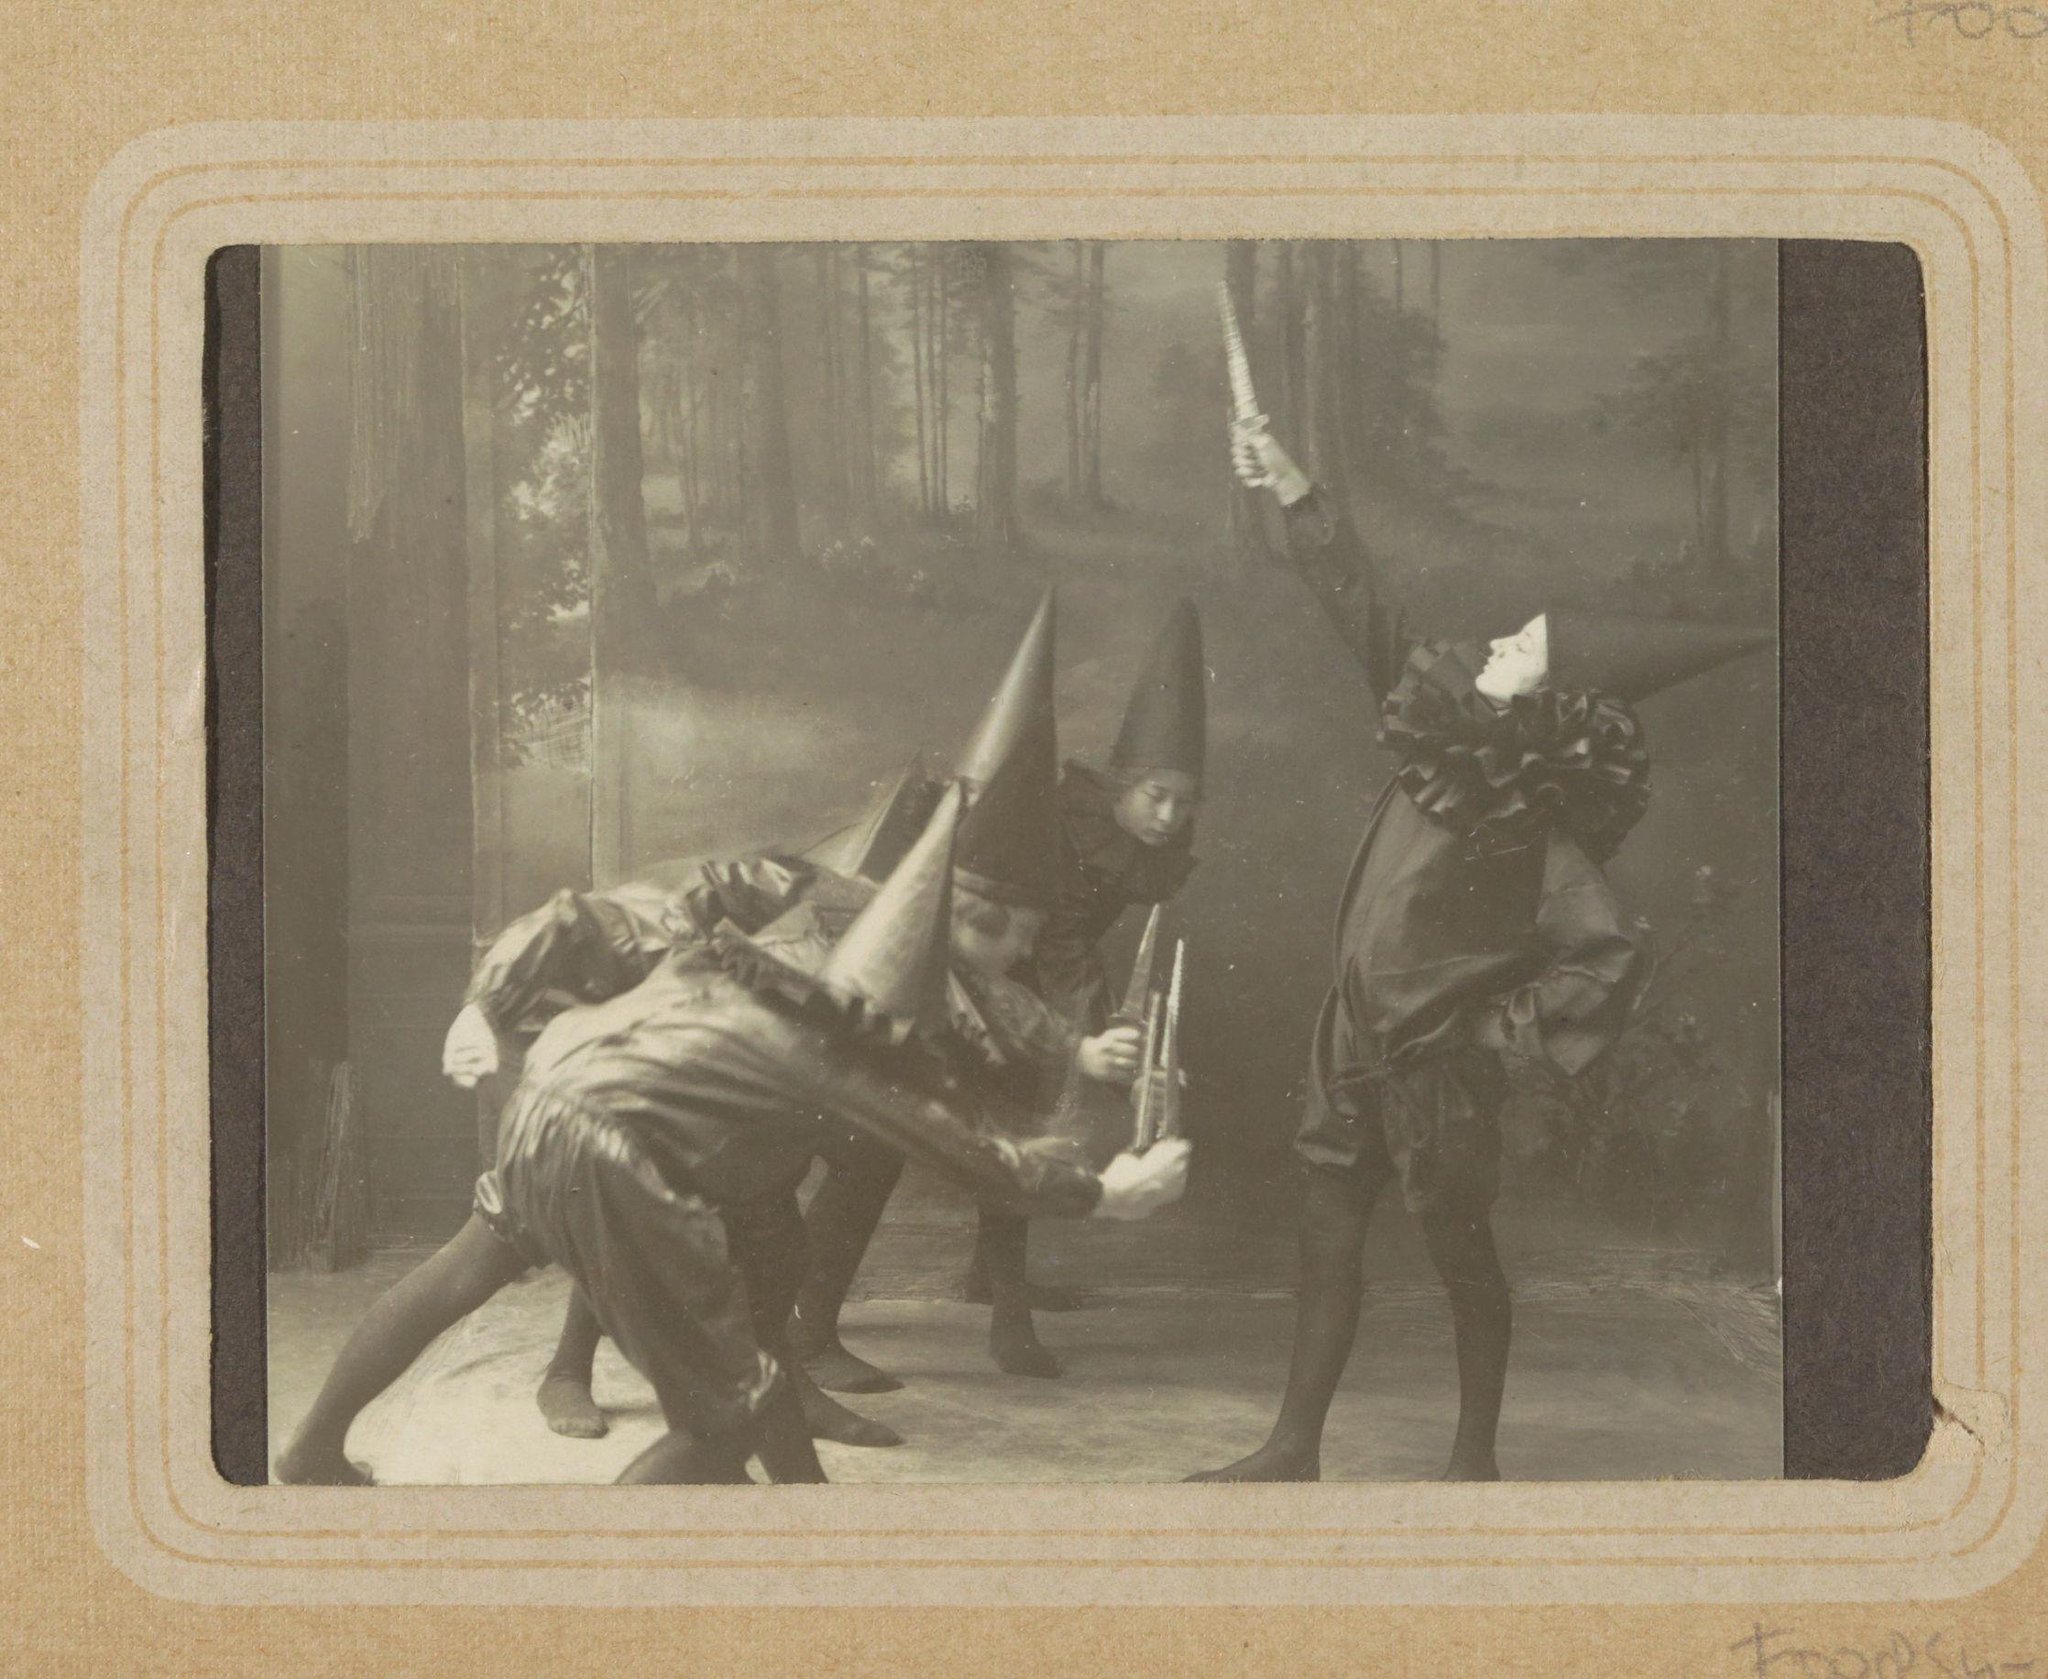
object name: photograph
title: Groepsportret van pastoor Bercio met zijn familie in Klein Koslau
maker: christian augustus ganderup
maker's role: fotograaf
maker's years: 1855-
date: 1890-1910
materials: paper, photographic support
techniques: collodion silver print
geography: klein koslau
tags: three generations (family group)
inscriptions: address: ‘Holbaek Nygade 7.’, inscription: ‘Clara Zimmermann mit [...] mit Werner [...]’, inscription: ‘Familie Bercio Klein Koslau 1898.’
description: Onderdeel van Fotoalbum van Carl Heinrich Fliegenschmidt, gevangenisdirecteur te Oslebshausen.